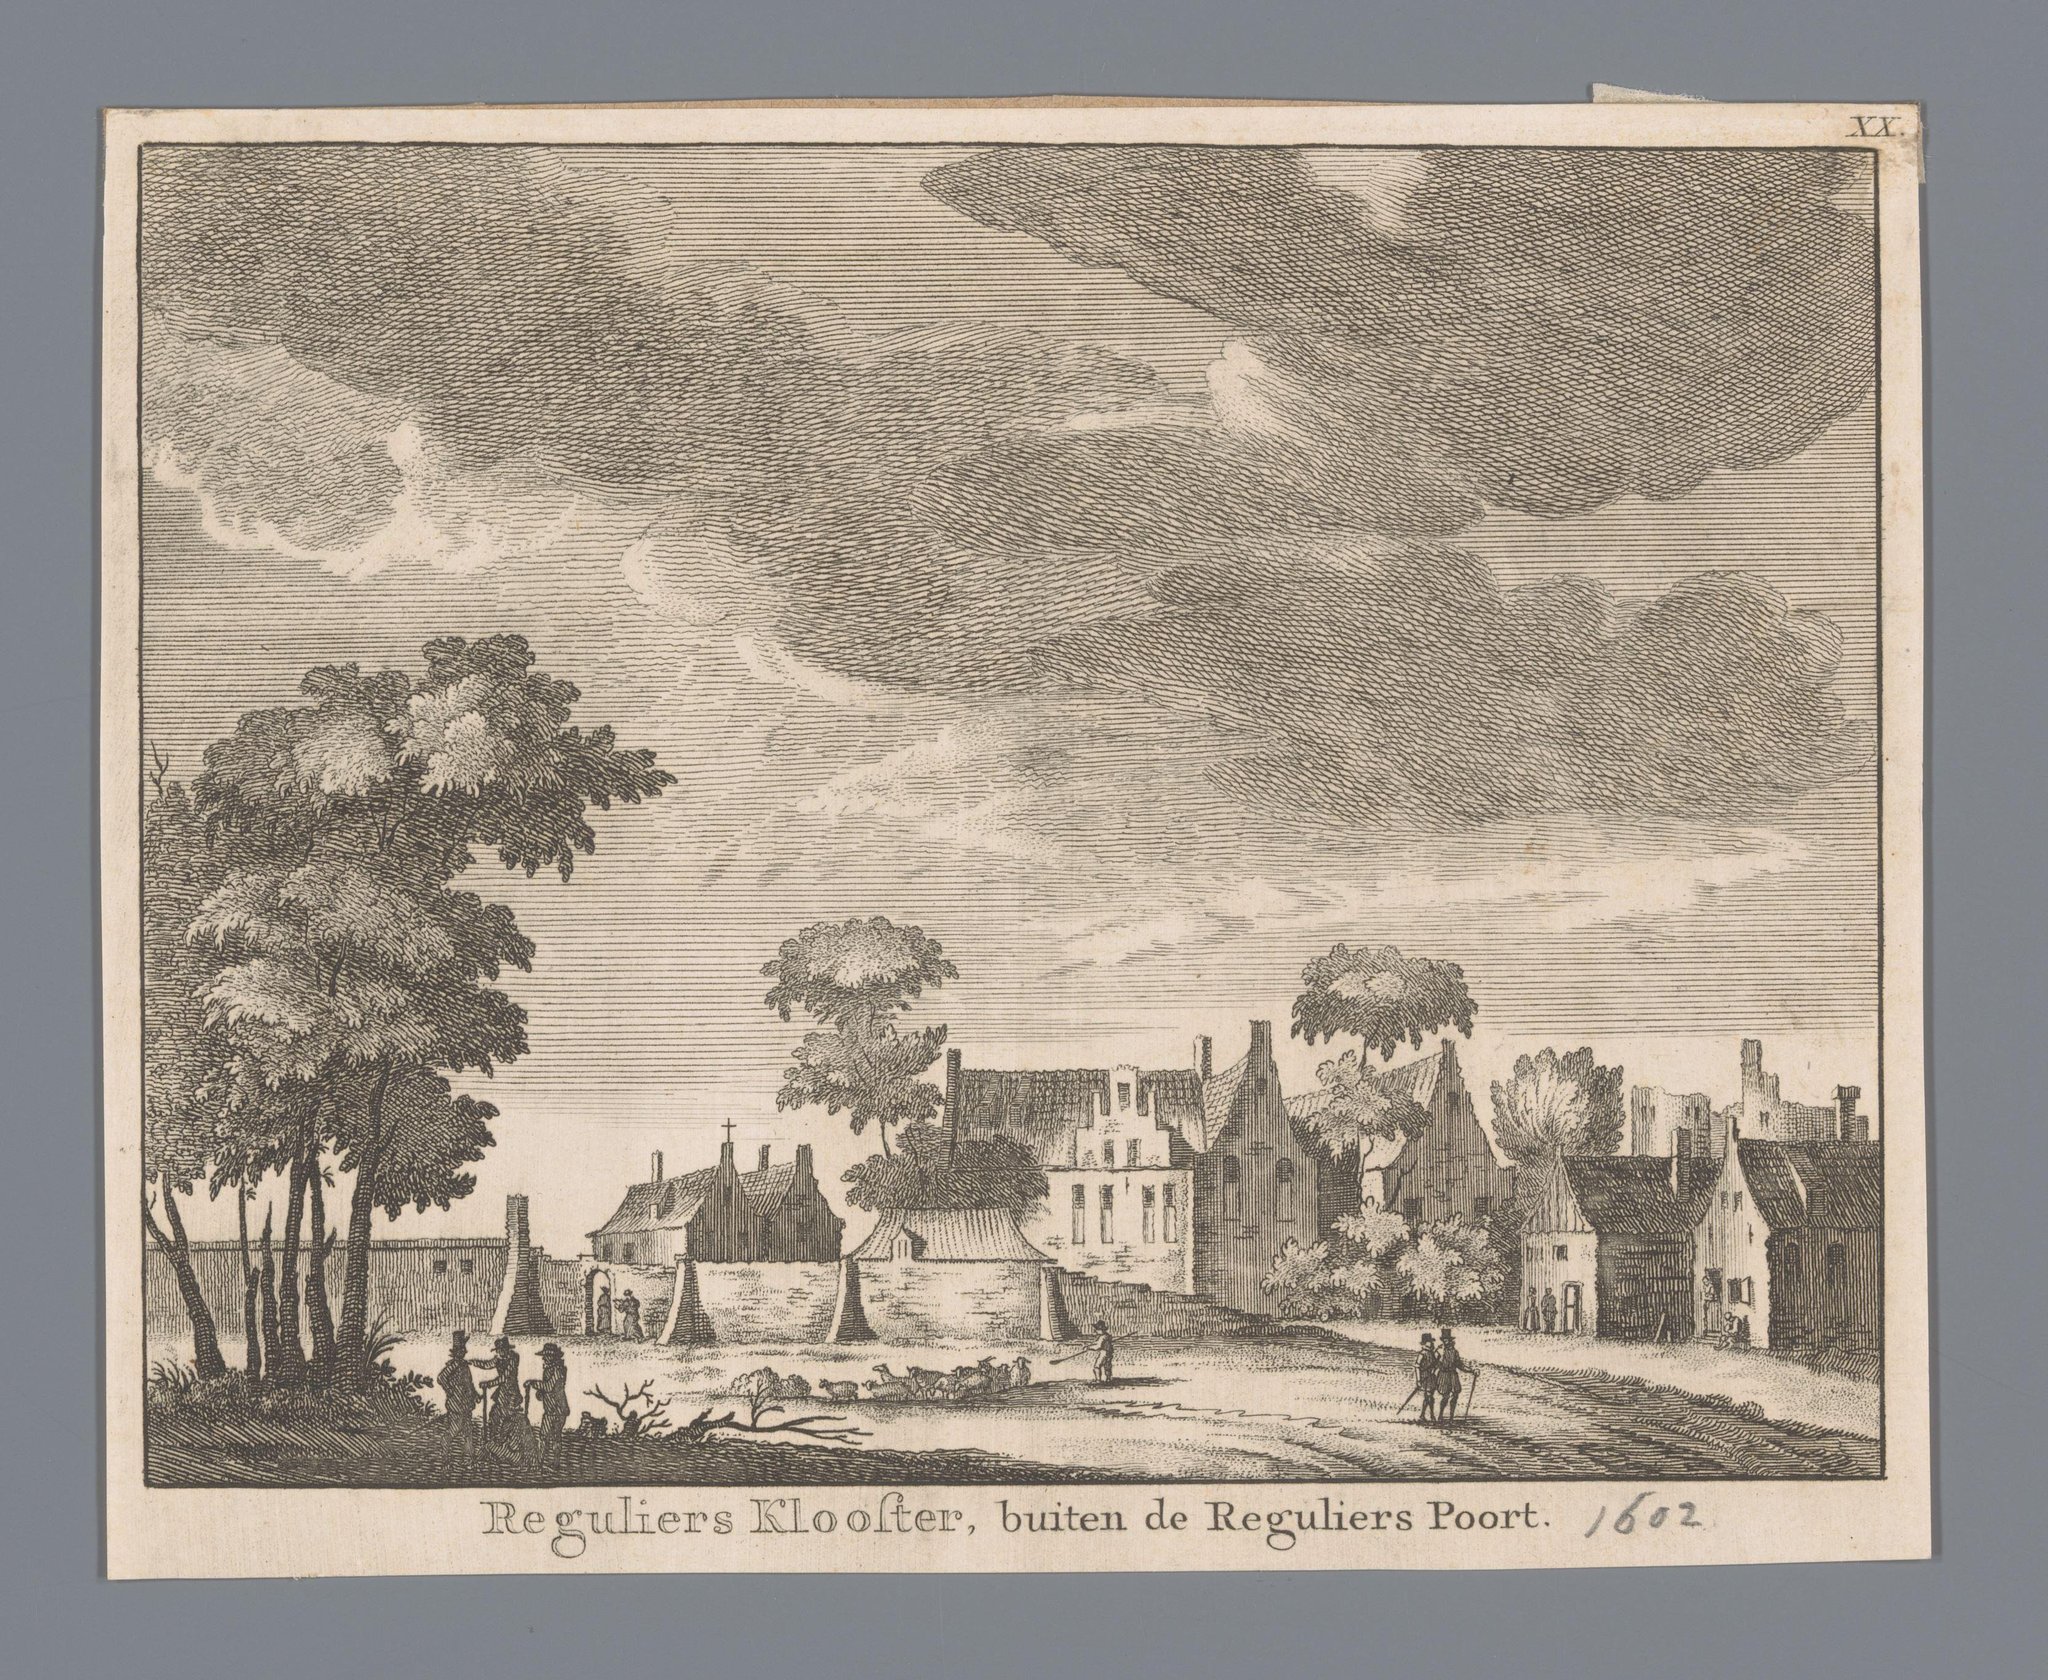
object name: print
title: Reguliers Klooster, buiten de Reguliers Poort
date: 1760-1767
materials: paper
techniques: etching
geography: amsterdam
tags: abbey, monastery, convent ~ roman catholic church, amsterdam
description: Prent verschenen in: Wagenaar, Jan. Amsterdam, in zyne opkomst, aanwas geschiedenissen, voorregten, koophandel, gebouwen, kerkenstaat, schoolen, schutterye, gilden en regeeringe, beschreven door Jan Wagenaar, historieschryver de Stad. Amsterdam: Isaak Tirion, 1760-1767.